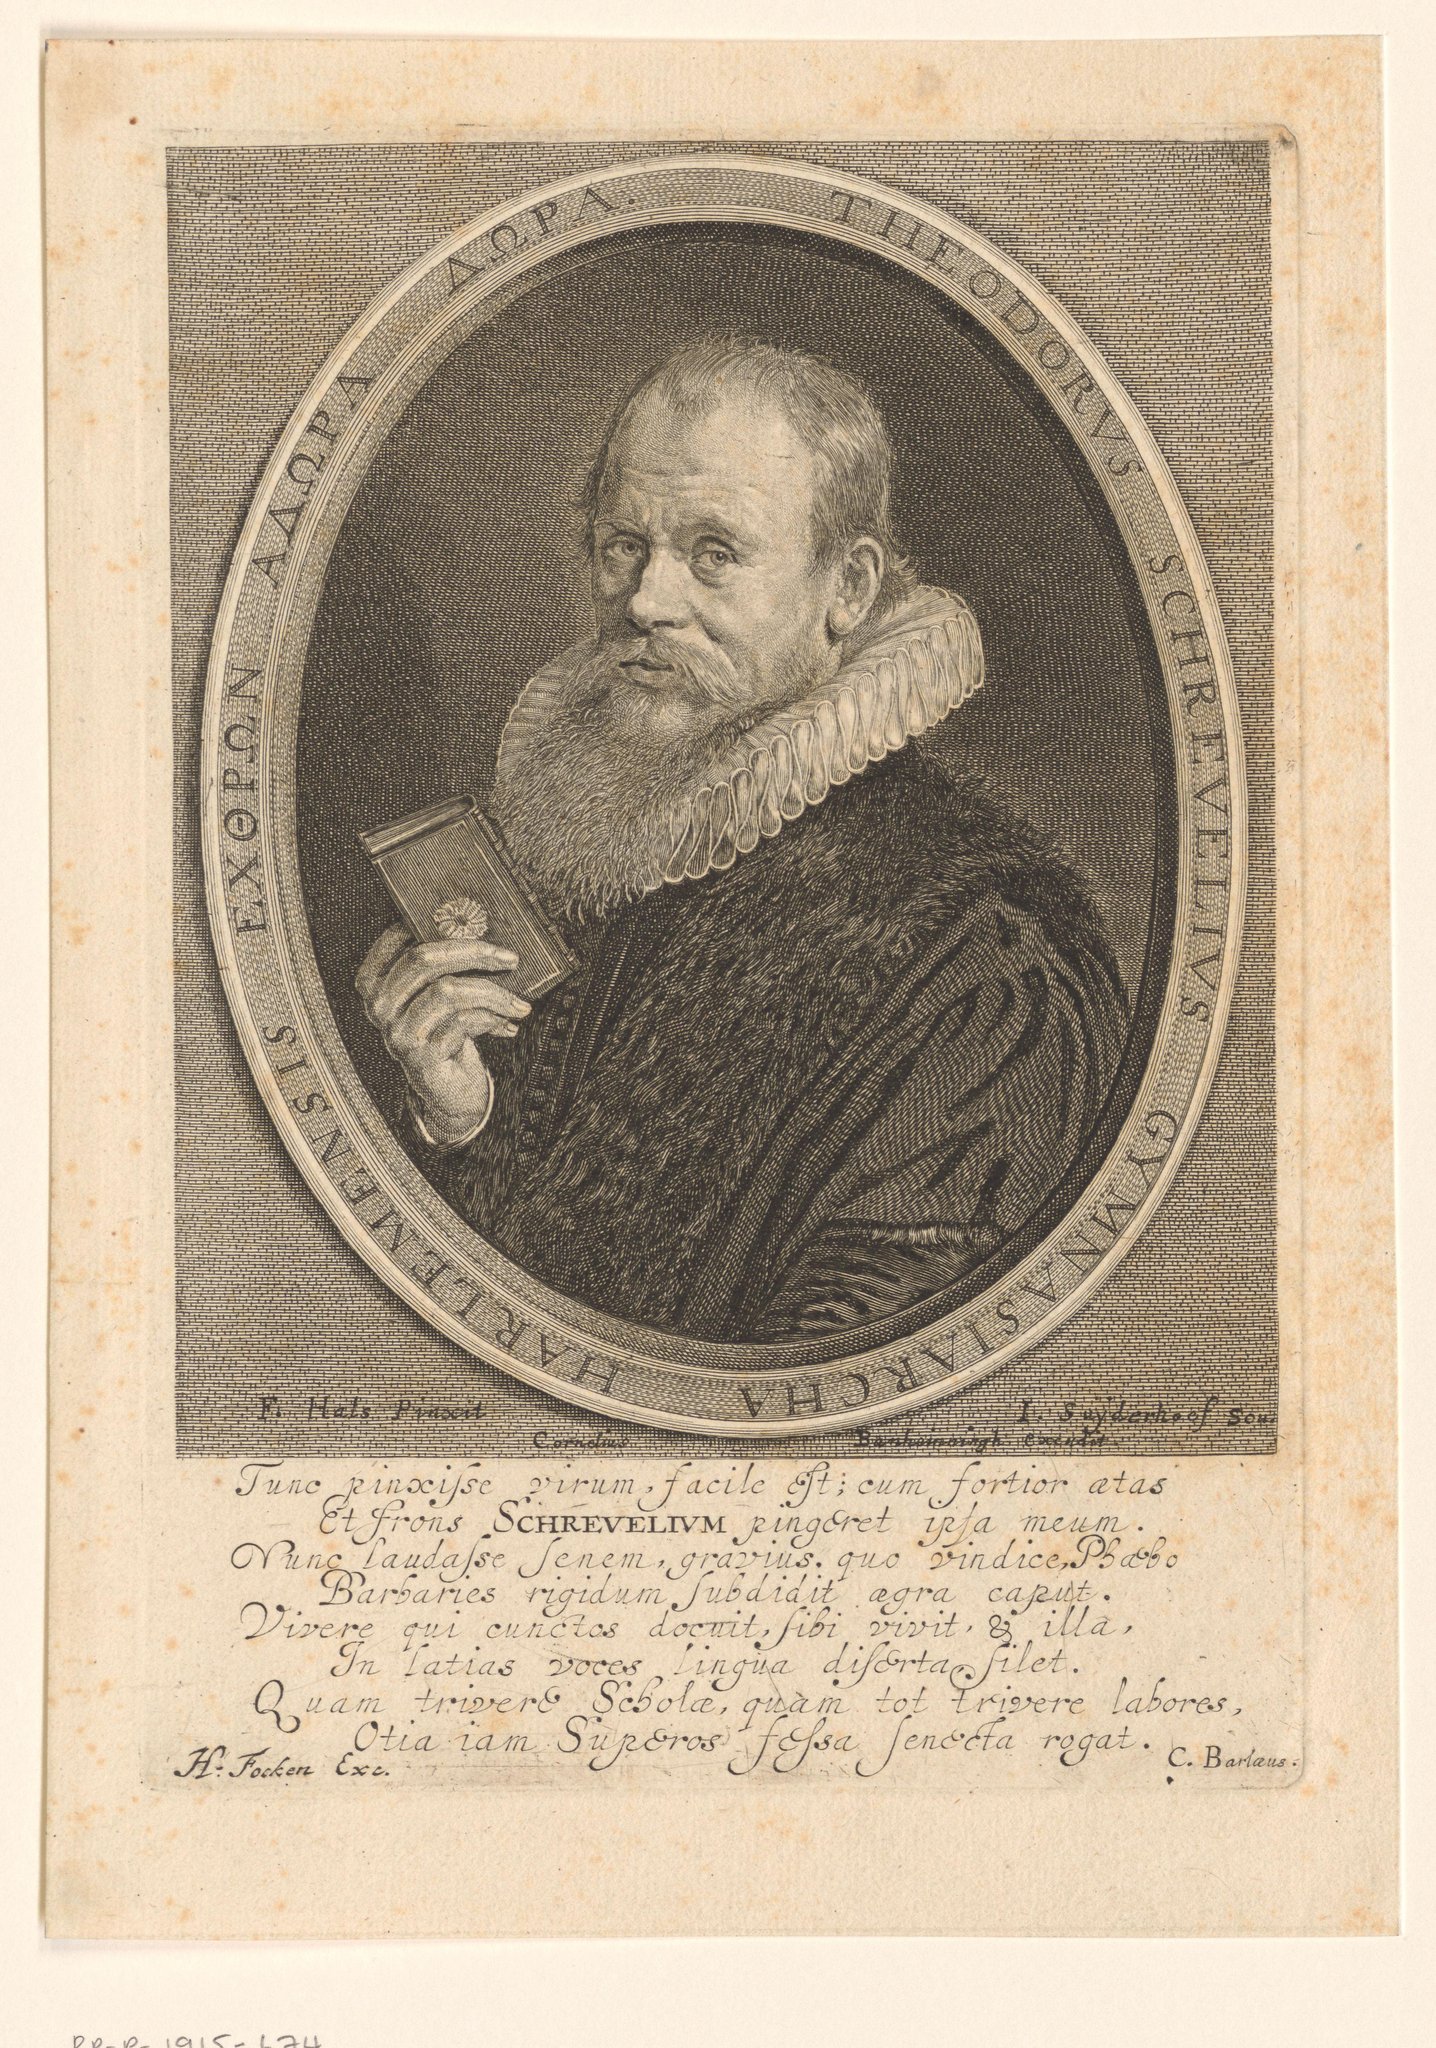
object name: print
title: Portret van Theodorus Schrevelius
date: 1665-1689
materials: paper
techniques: engraving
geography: amsterdam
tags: haarlem, leiden, theodorus schrevelius, historical persons, book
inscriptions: collector's mark: Lugt 2228